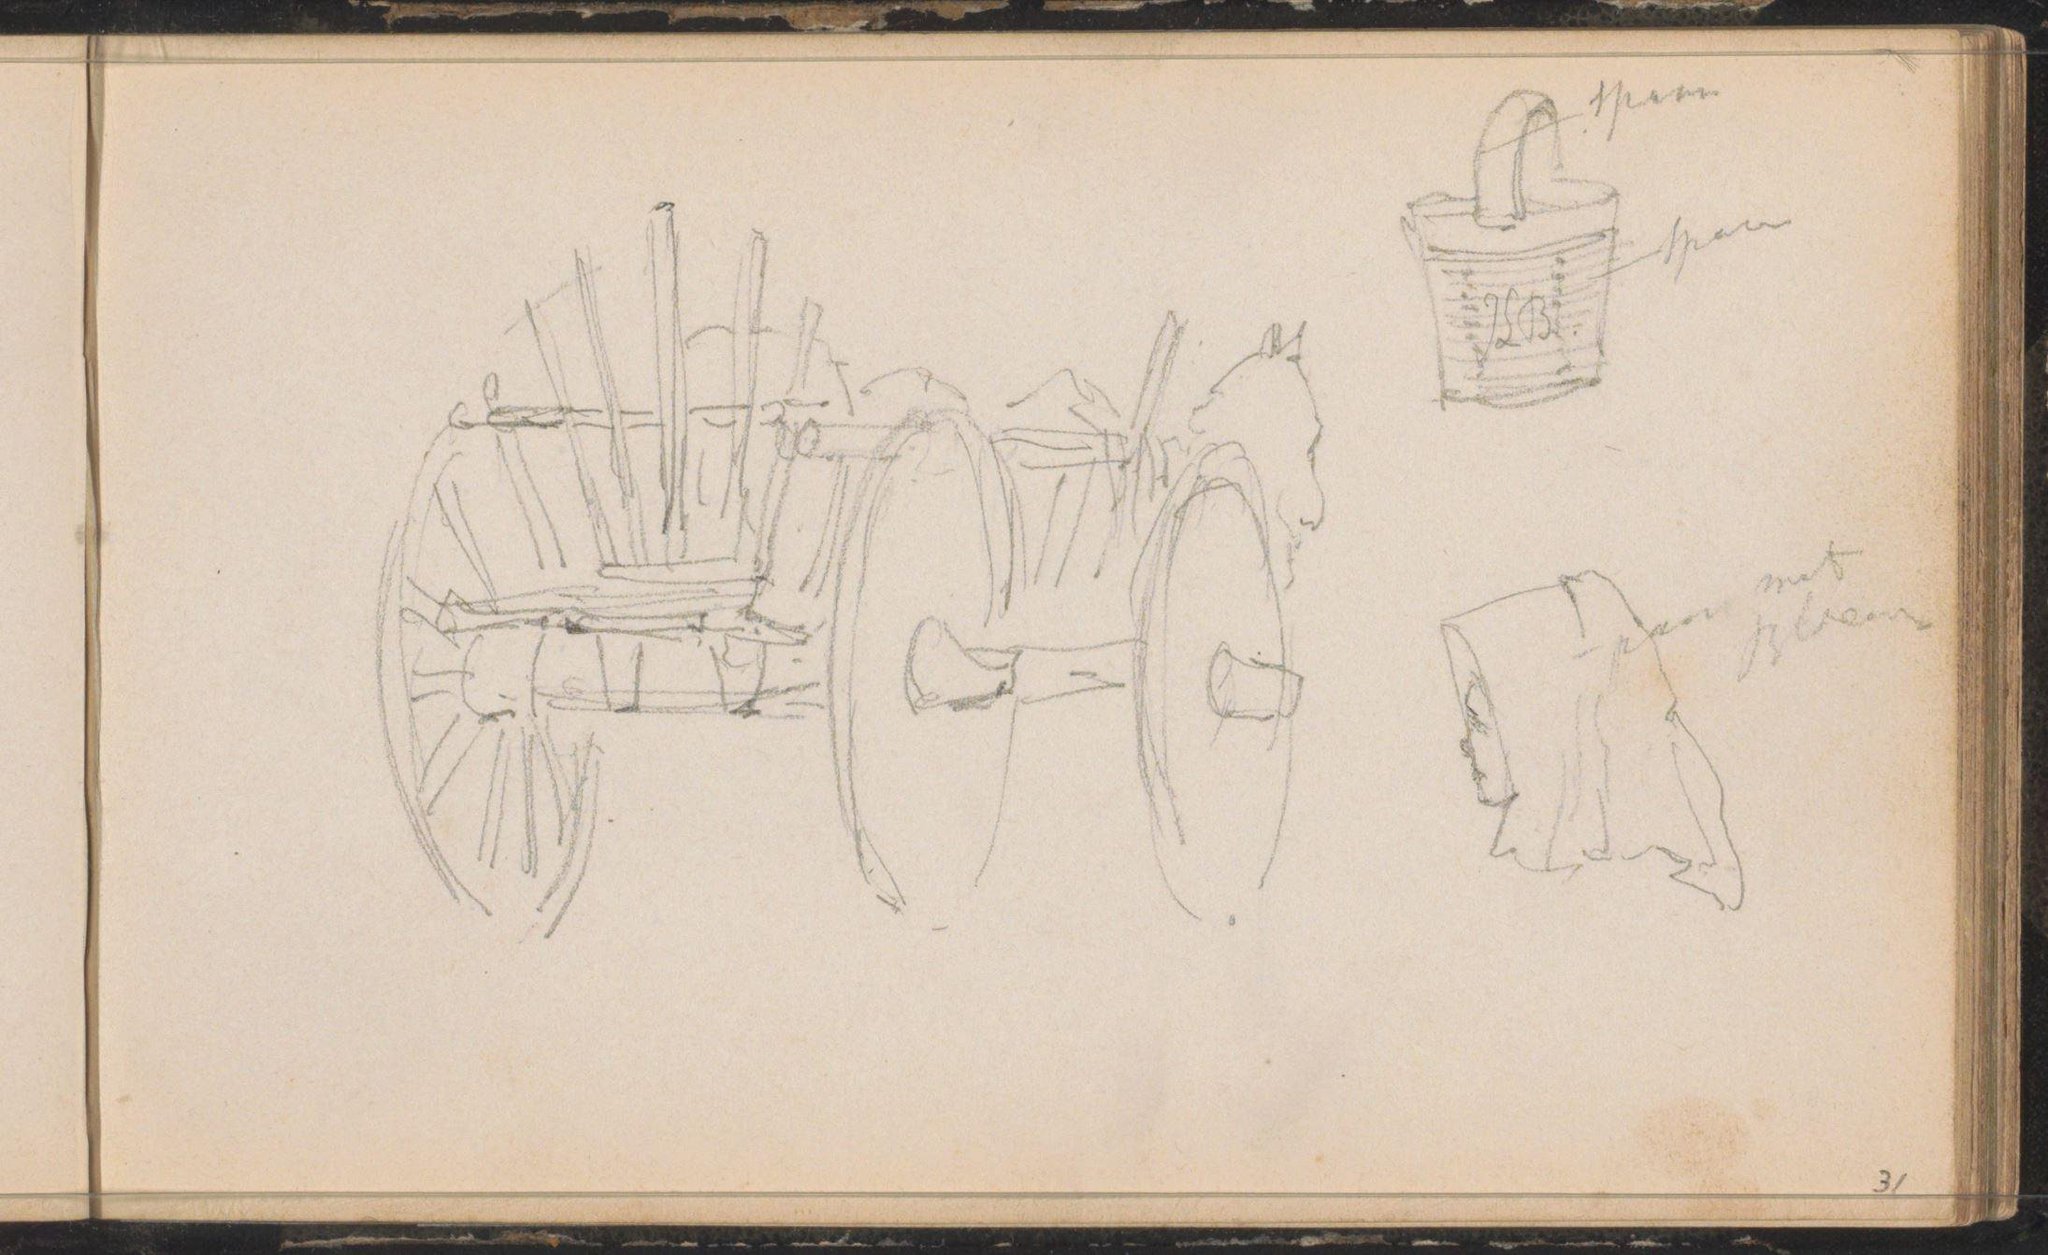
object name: sketchbook leaf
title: Paard-en-wagen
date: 1863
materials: paper, pencil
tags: head-gear, container made of plant material other than wood: basket, horse, (farm) wagon, freight wagon, cart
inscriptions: kleurnotitie, handgeschreven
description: Links een paard-en-wagen. Rechts een mand en een vrouwenhoofd met een muts. Blad 31 uit een schetsboek met 55 bladen vervaardigd op de Veluwe en in Noord-Duitsland.